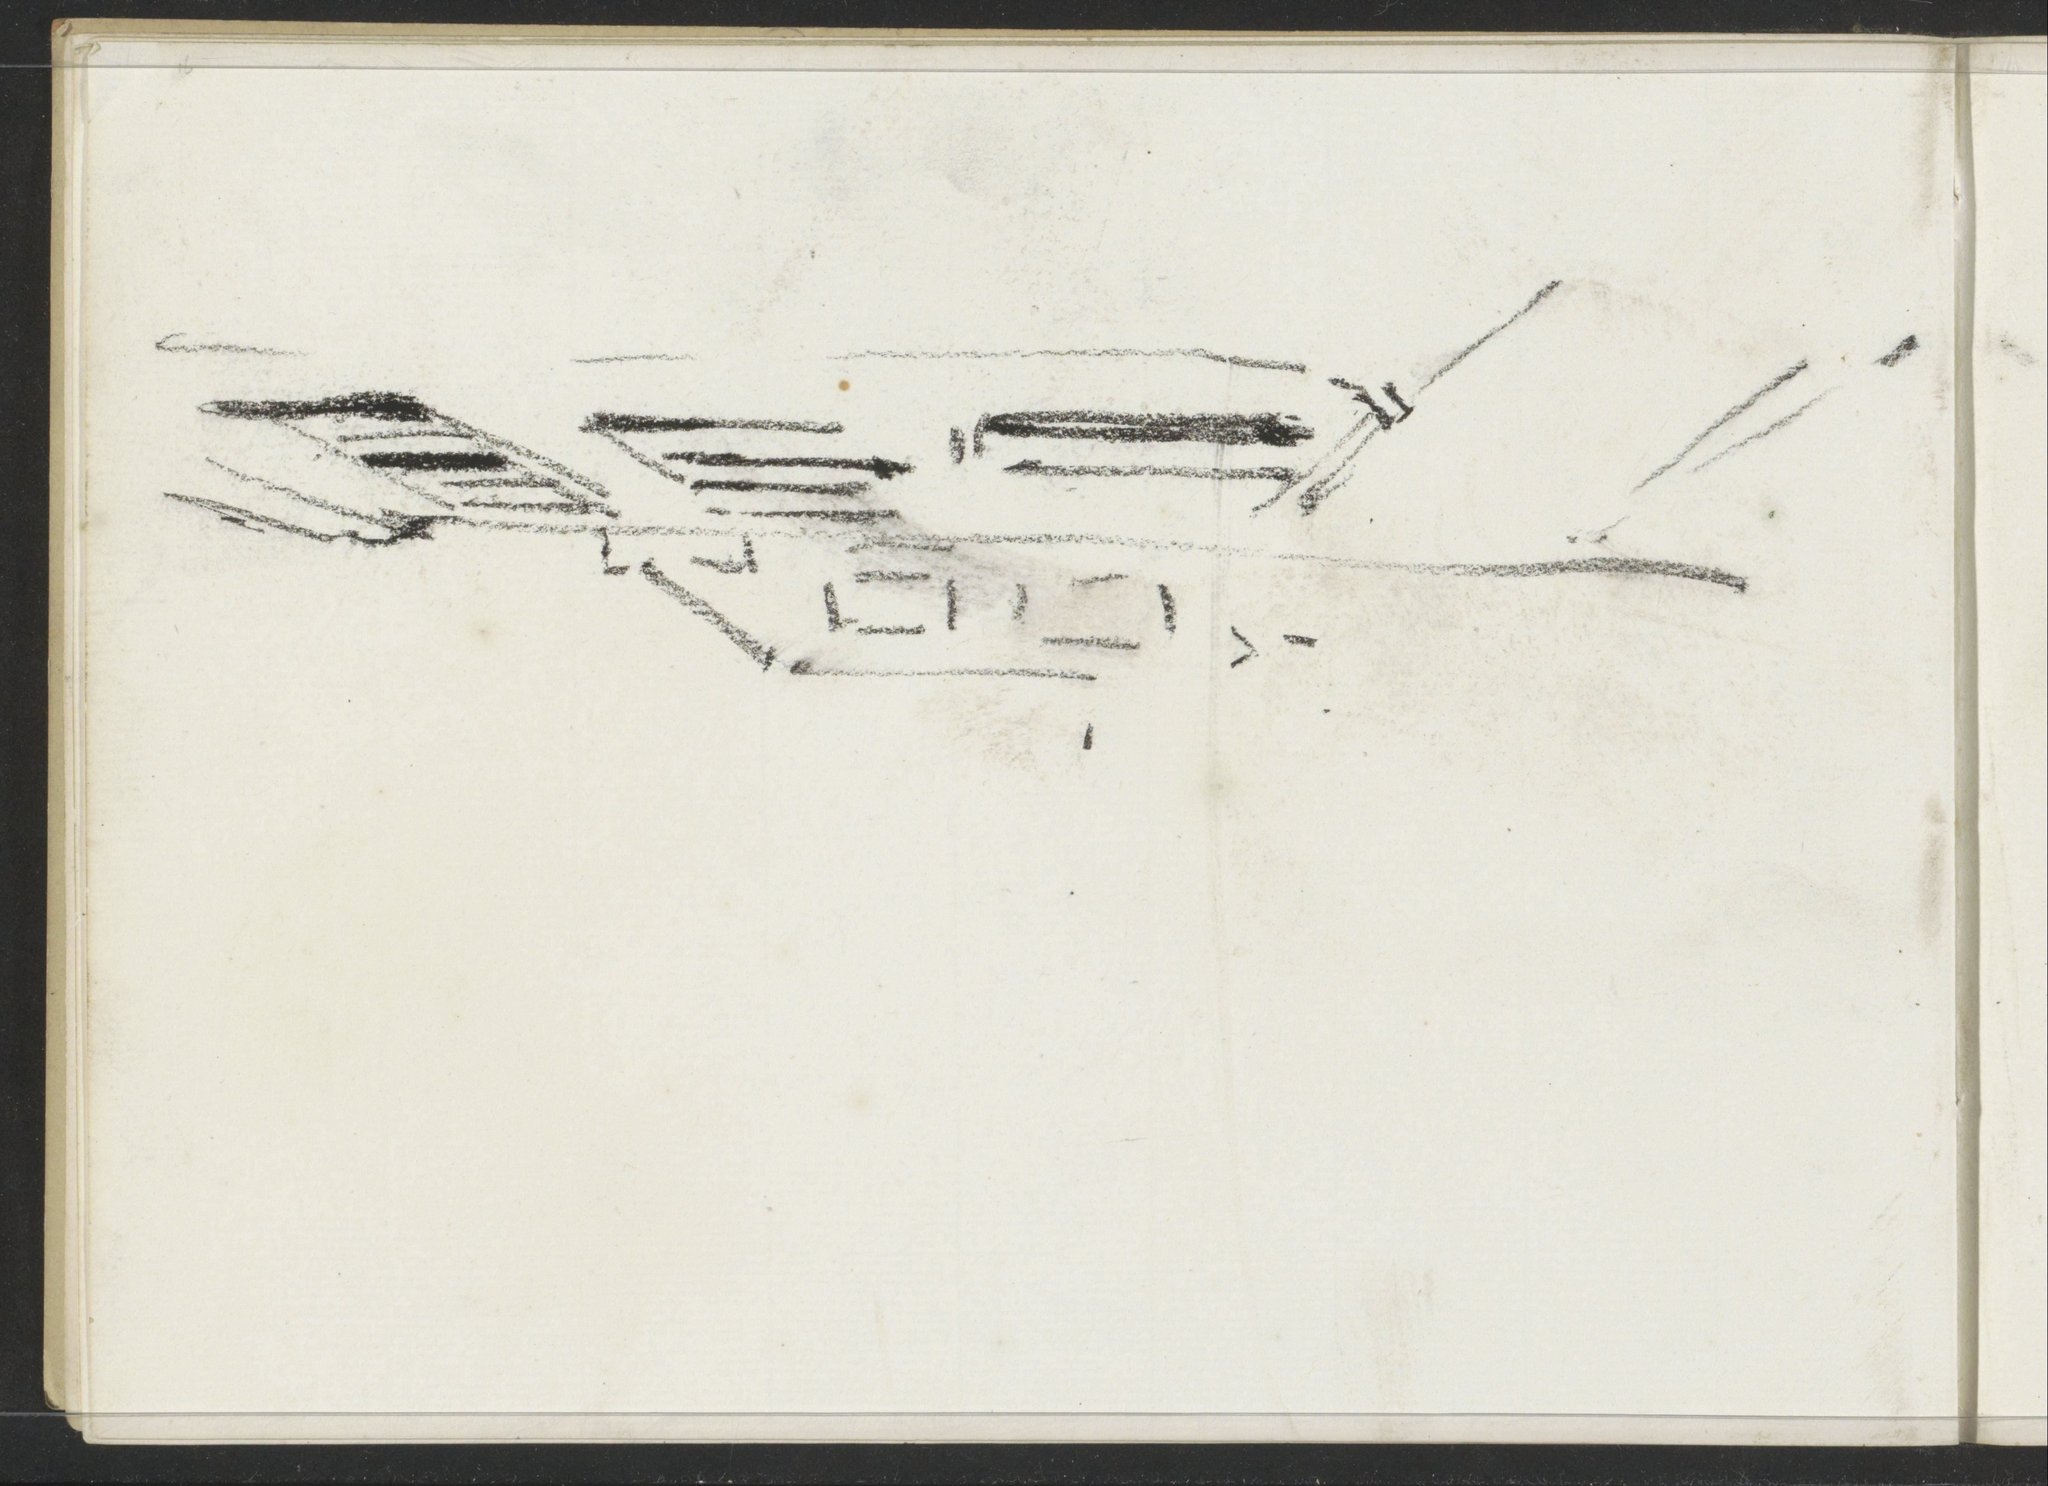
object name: sketchbook leaf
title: Twee gevels, waaronder een tuitgevel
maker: willem witsen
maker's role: draughtsman, painter, print maker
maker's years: 1860-1923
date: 1897-1900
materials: chalk, paper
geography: amsterdam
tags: façade (of house or building), amsterdam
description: Pagina 16 uit een schetsboek met 13 bladen.